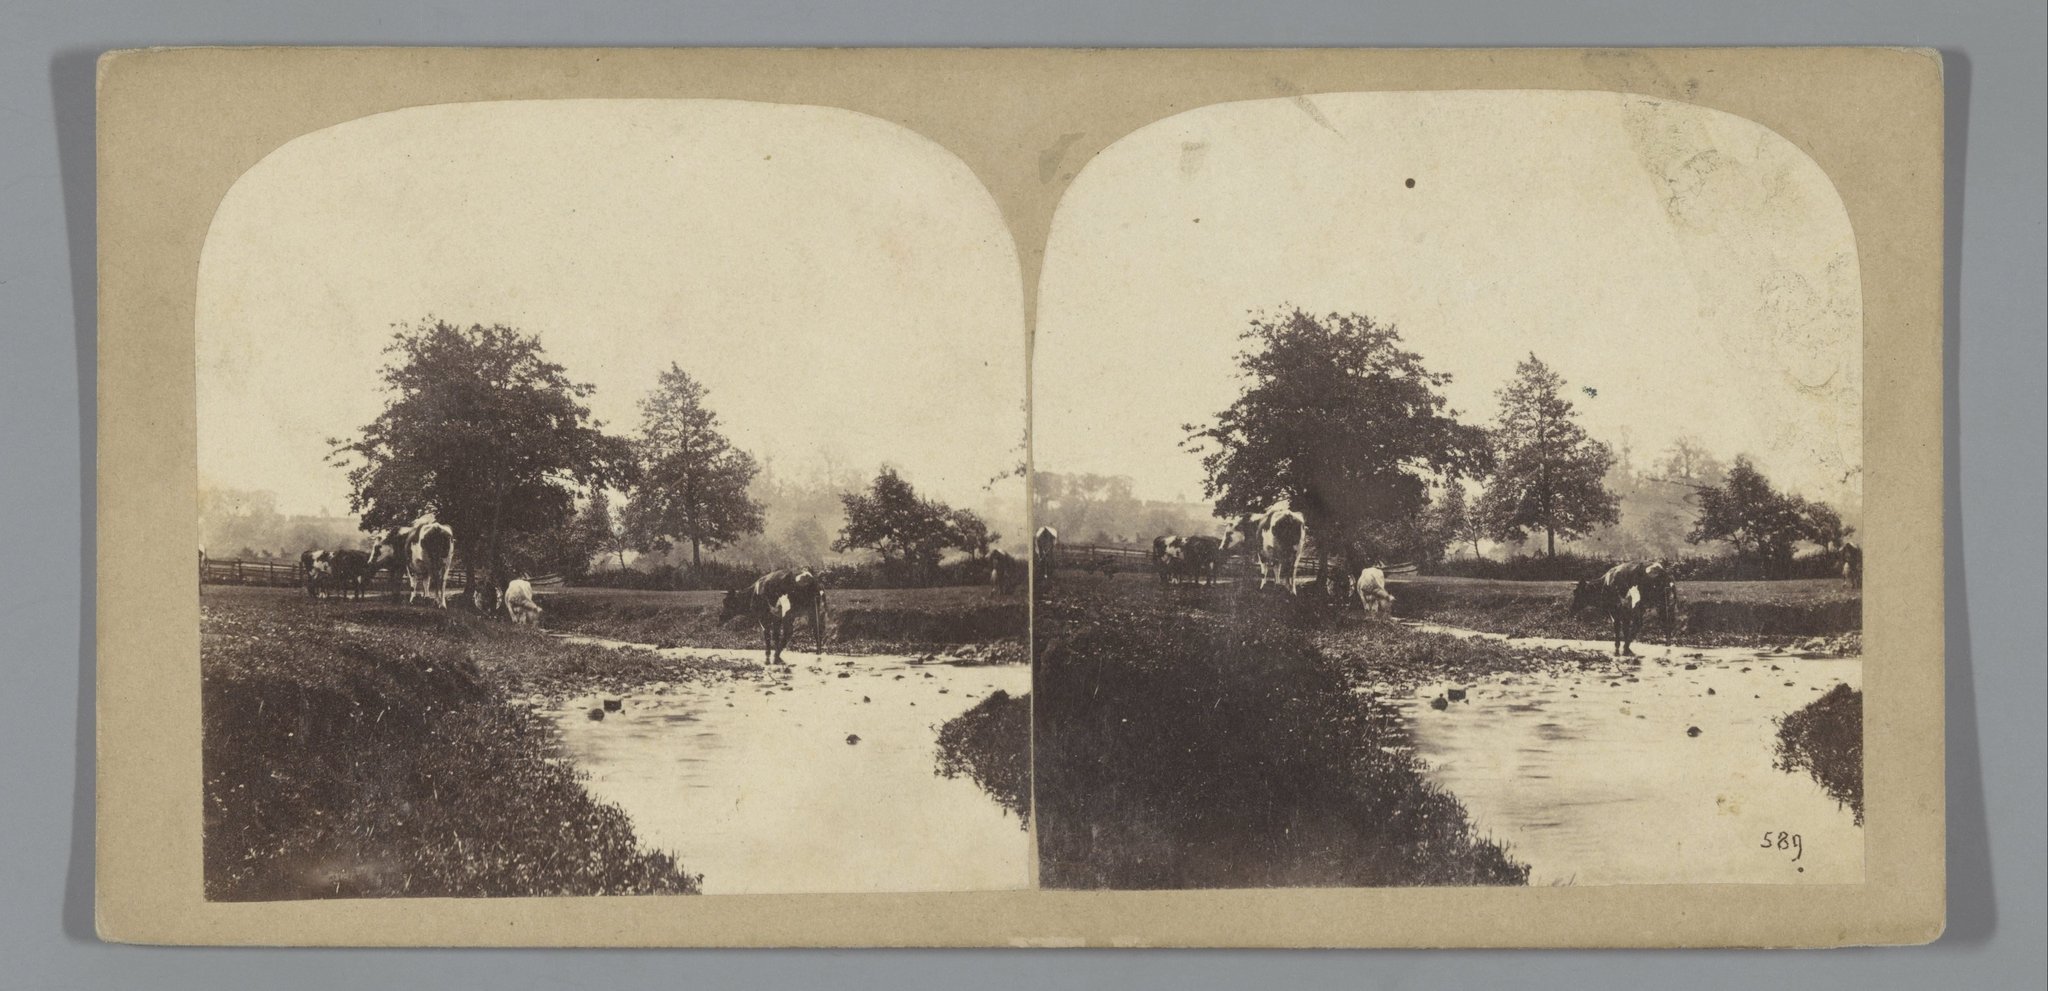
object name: stereograph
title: Koeien in een landschap met water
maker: Anonymous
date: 1852-1858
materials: cardboard, paper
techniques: albumen print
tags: cow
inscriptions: number: ‘589’